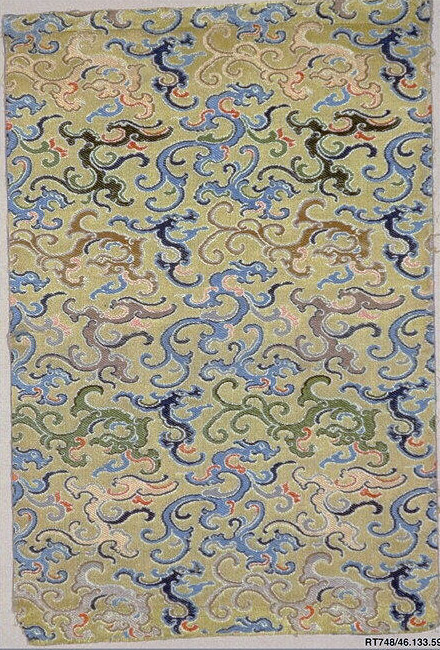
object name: piece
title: Textile with Dragons, Phoenixes, and Other Animals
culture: chinese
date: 1701-1800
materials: silk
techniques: lampas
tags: dragons